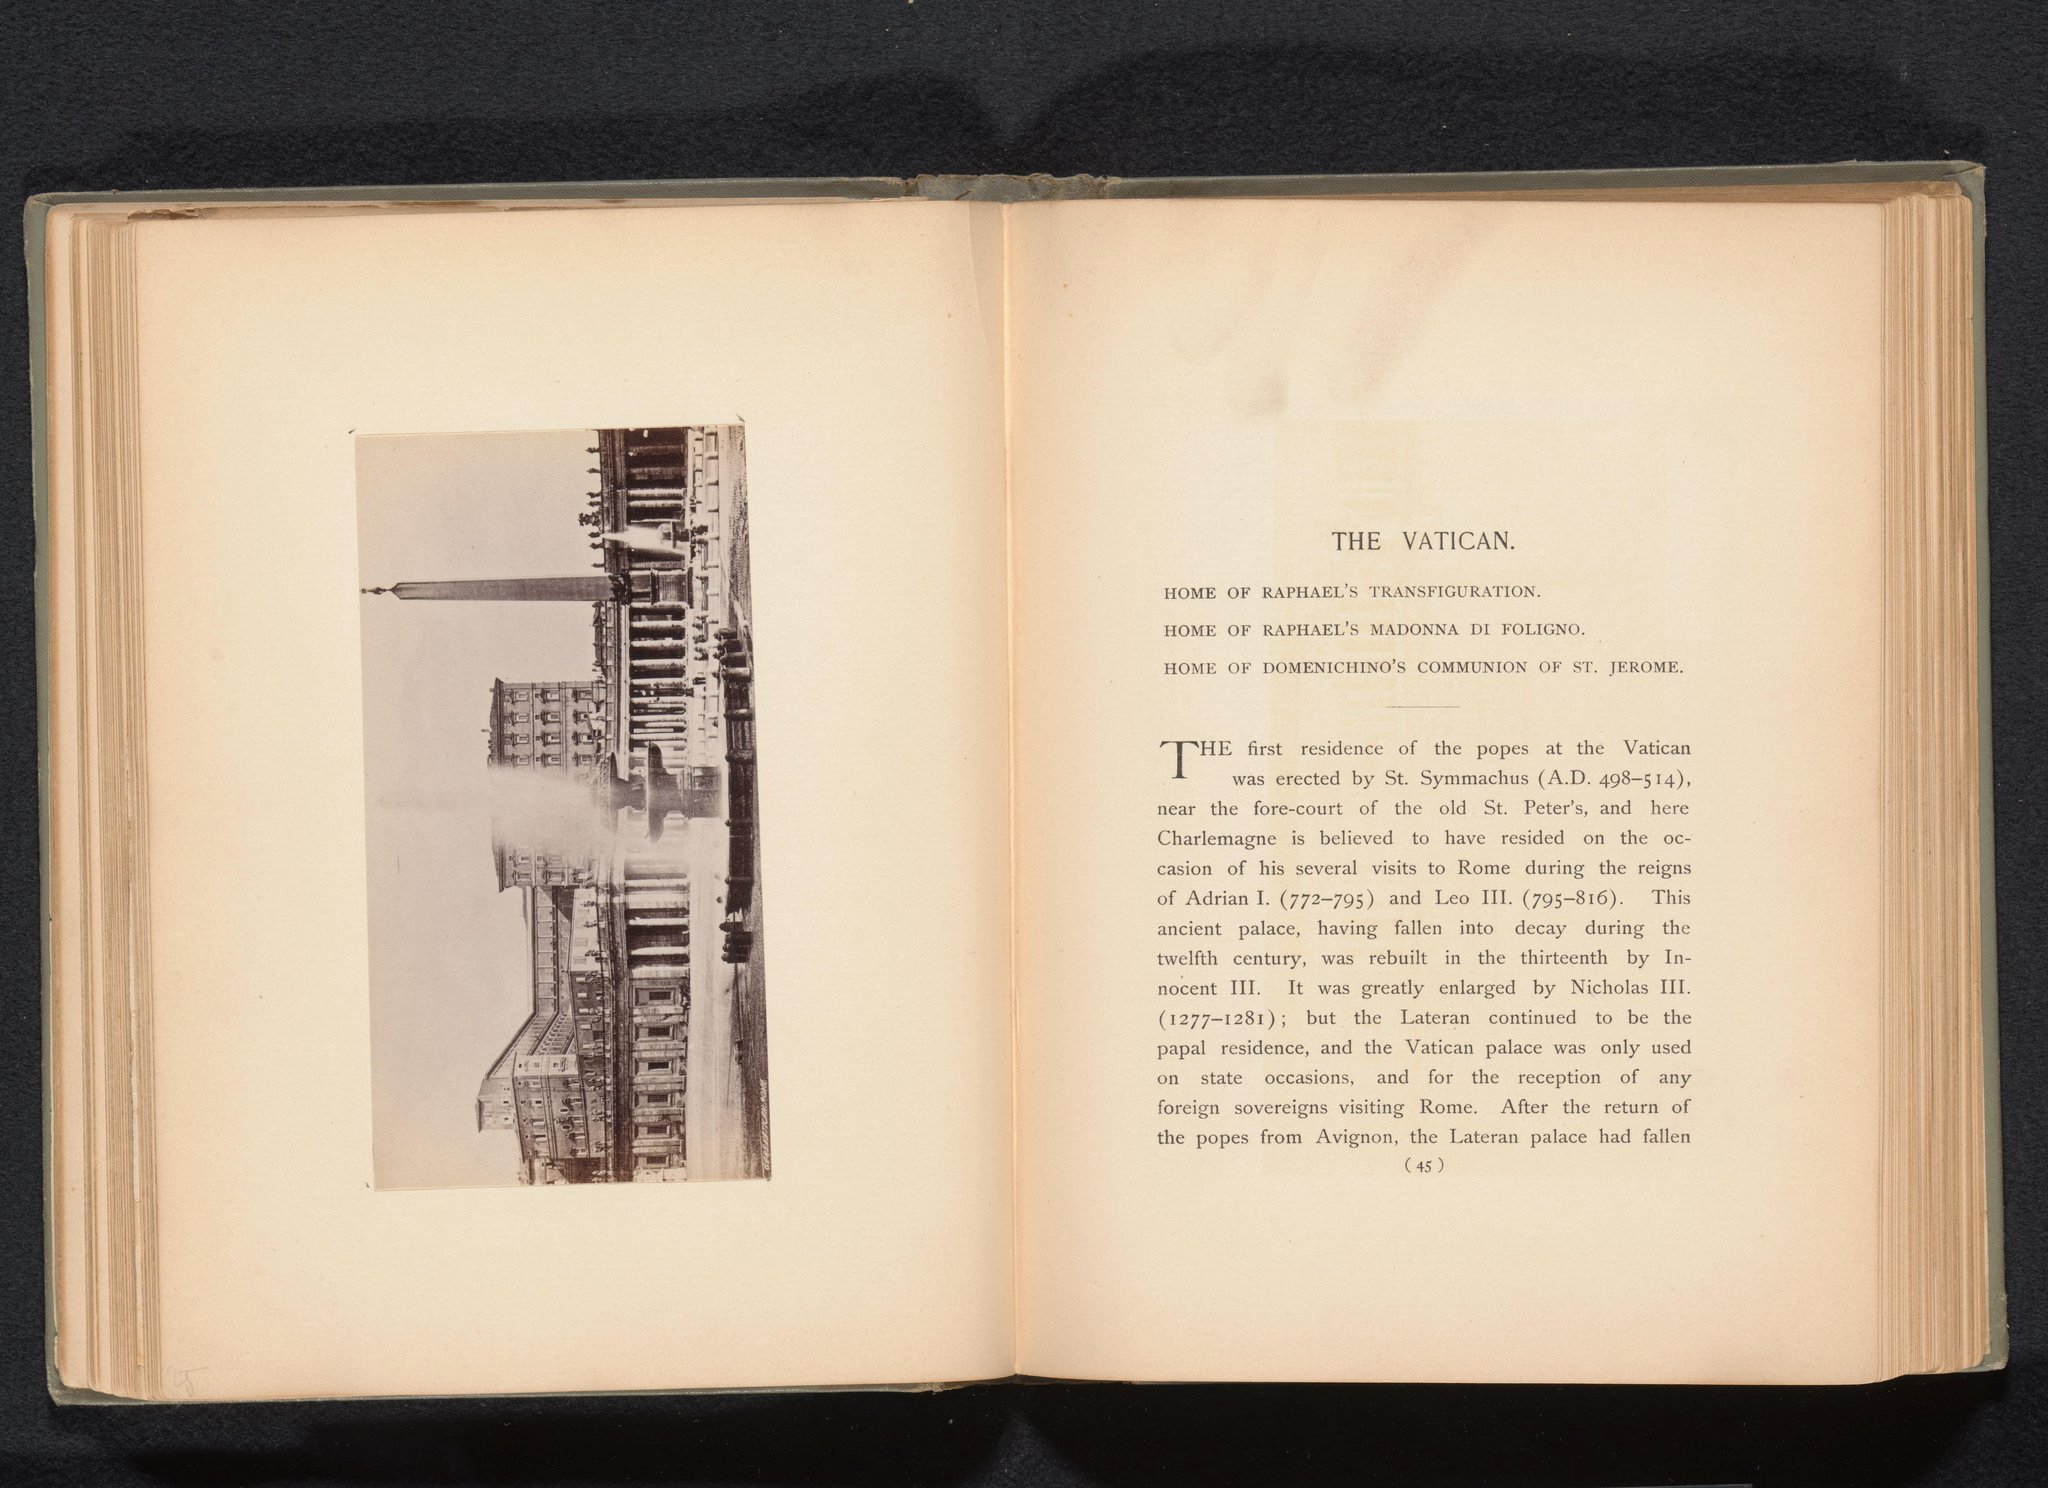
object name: photograph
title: Vatican, Rome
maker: Anonymous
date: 1882-1887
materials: photographic support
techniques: albumen print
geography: sint-pietersplein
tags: palace, ornamental fountain, façade (of house or building)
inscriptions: number: ‘6485’